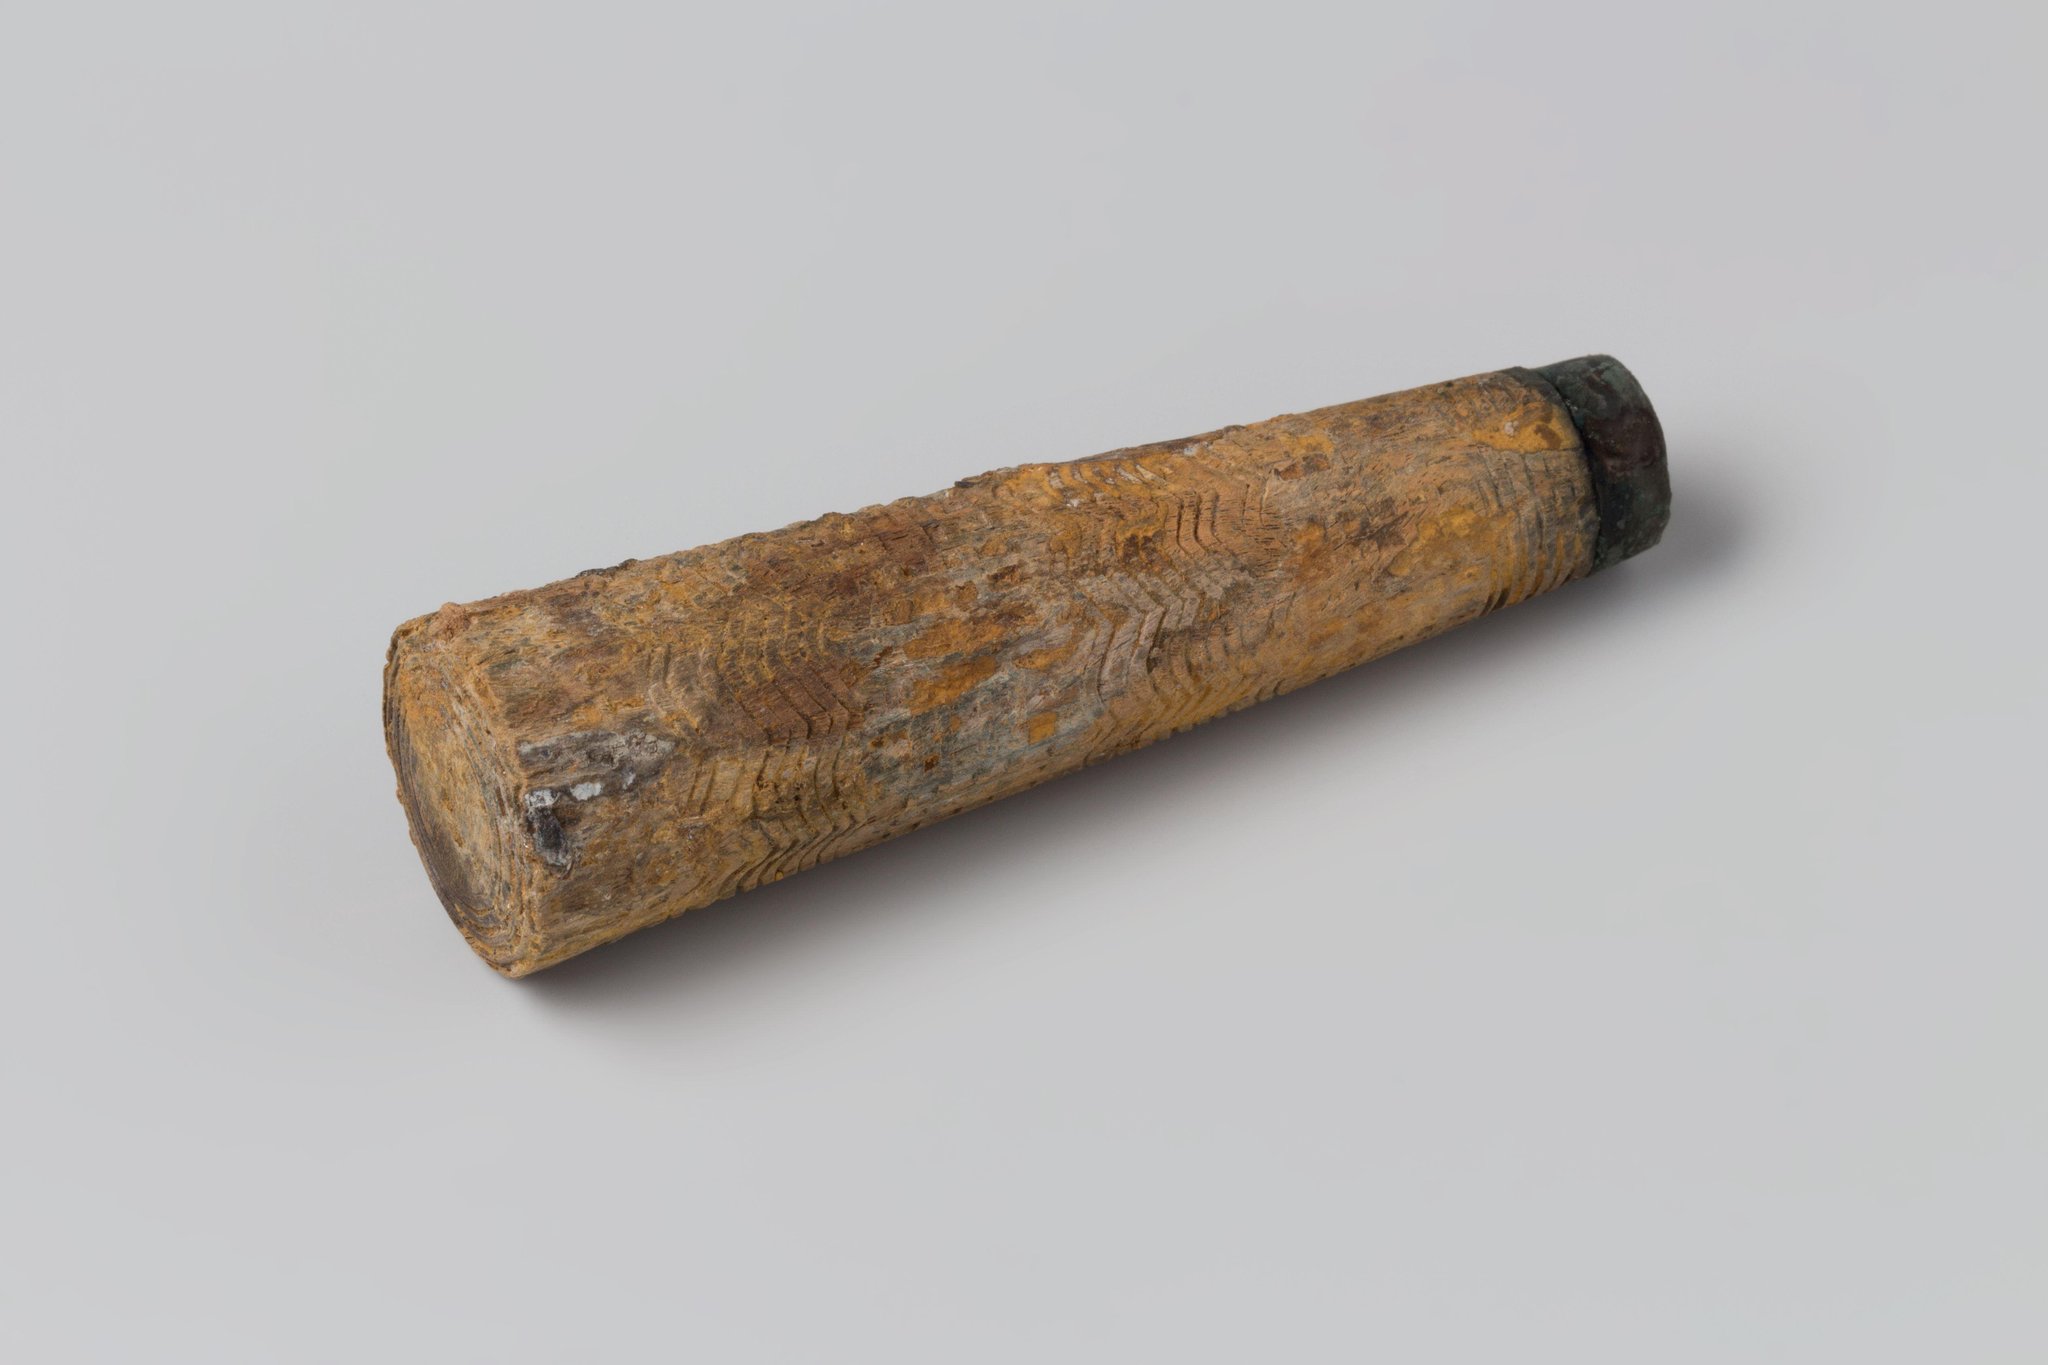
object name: knife handle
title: Messenheft uit het wrak van de Oost-Indiëvaarder Hollandia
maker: Anonymous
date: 1700-1743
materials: copper, wood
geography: netherlands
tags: verenigde oostindische compagnie, hollandia (schip), annet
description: Knife, handle, cylindrical: tapering; id. NG 1979-403H, ferrule, id. NG 1980-27H426.